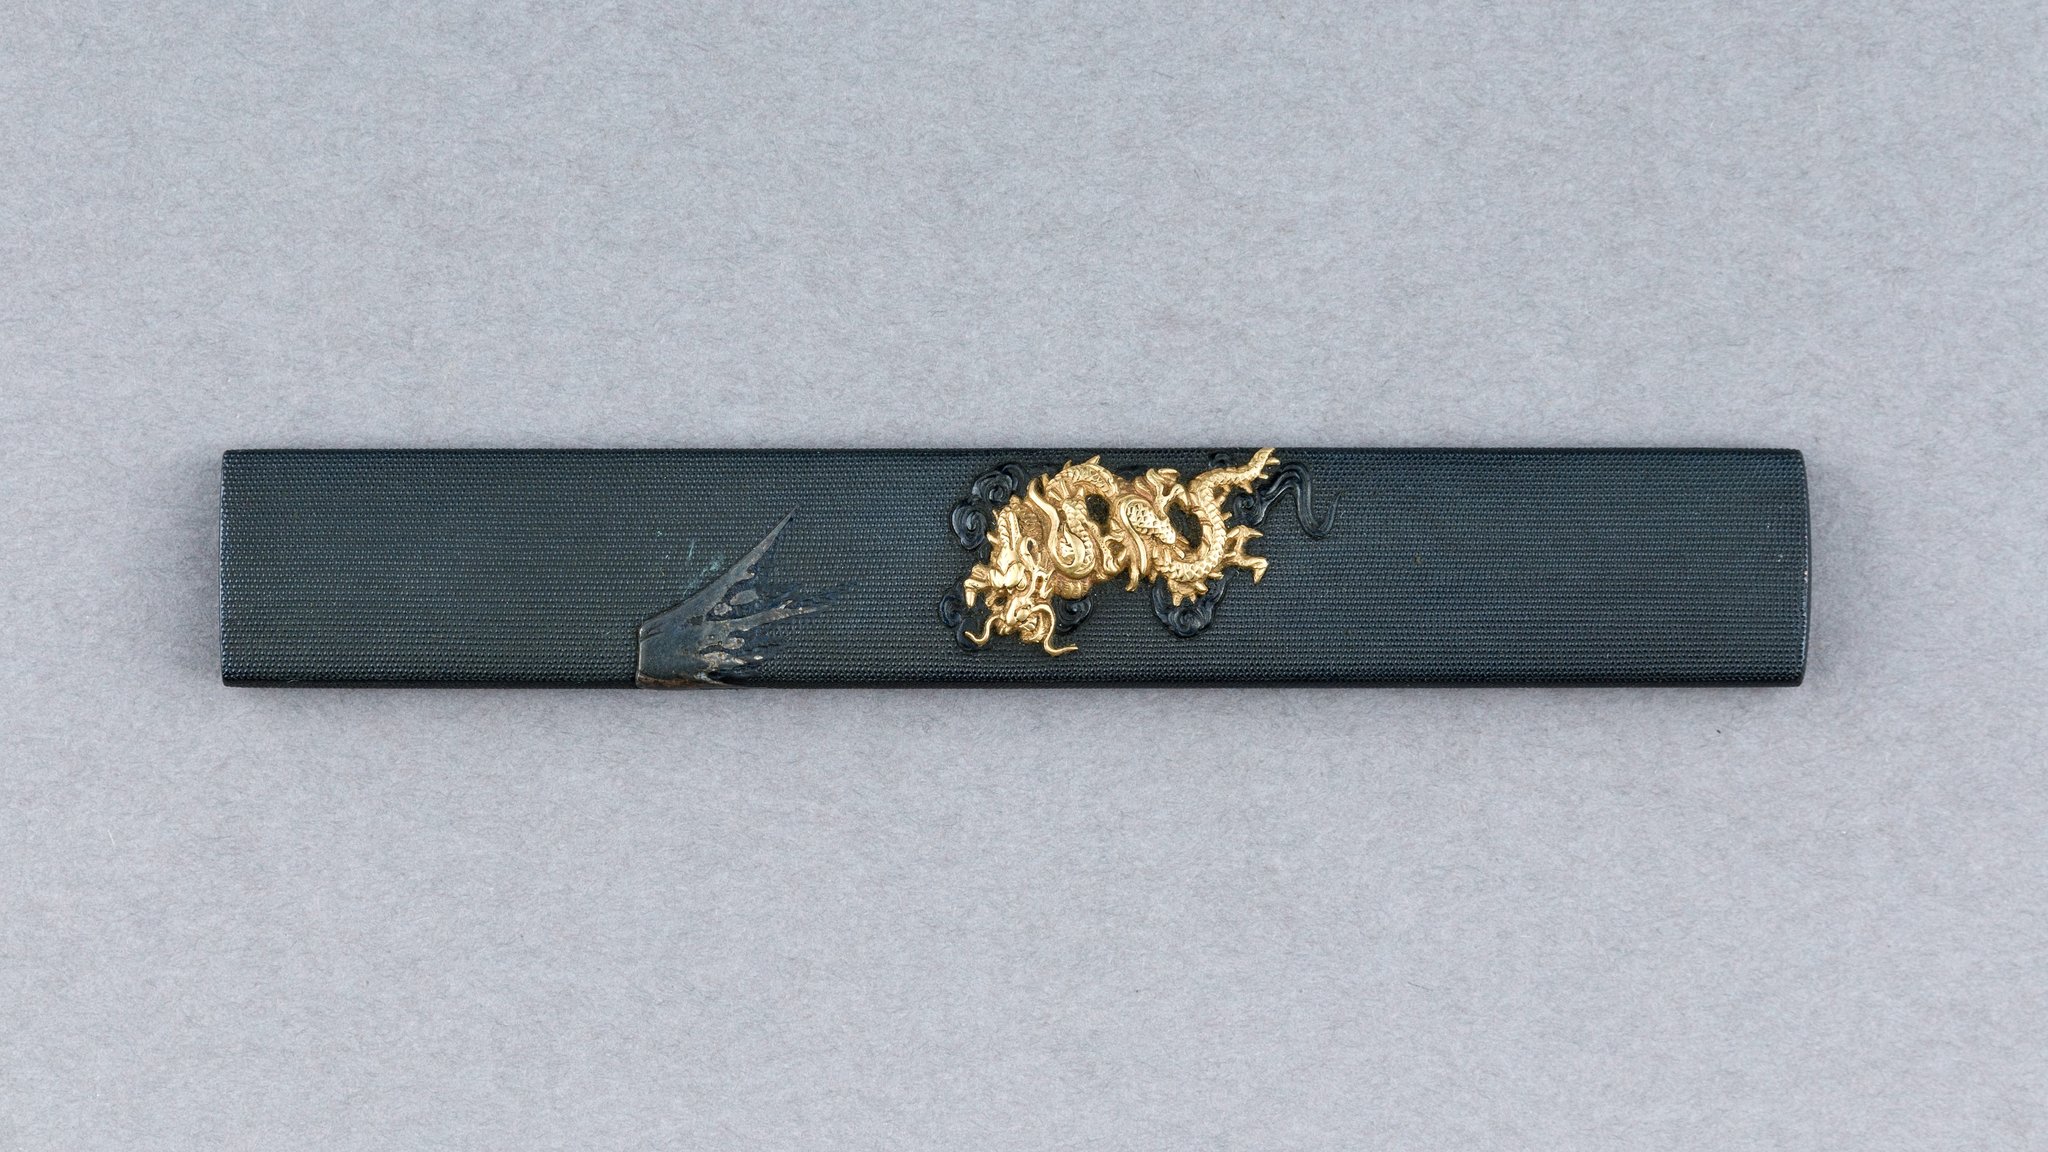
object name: knife handle kozuka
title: Knife Handle (Kozuka)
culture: japanese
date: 1615-1868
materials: gold alloy, gold, silver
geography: japan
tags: dragons